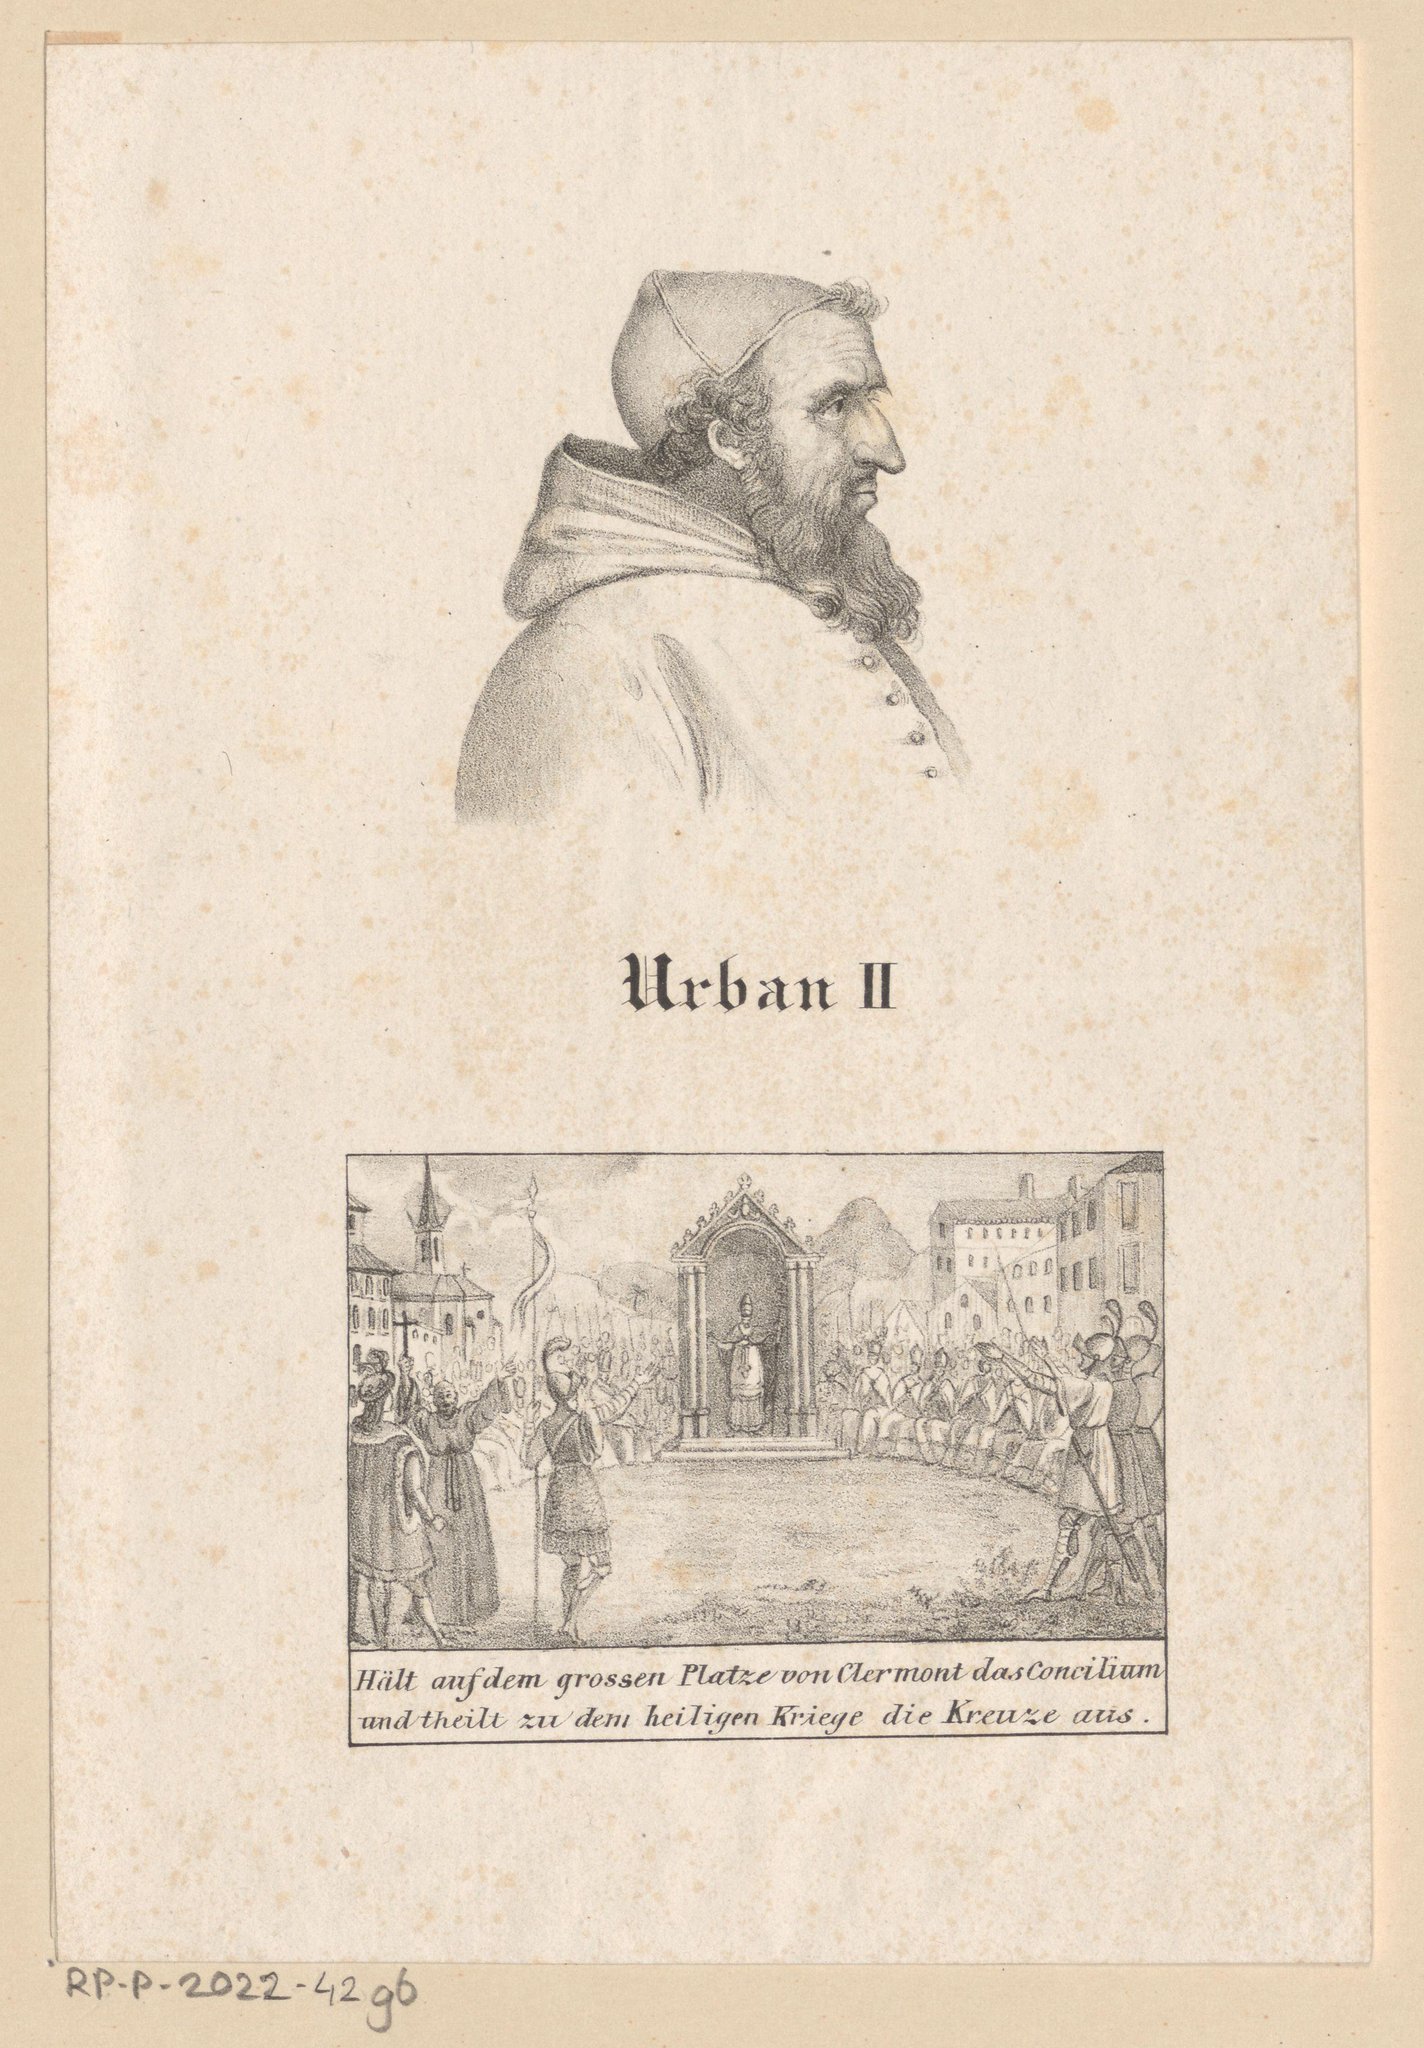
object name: print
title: Oproep tot de eerste kruistocht in Clermont met het portret van paus Urbanus II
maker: Anonymous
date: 1800-1899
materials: paper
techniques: lithograph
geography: germany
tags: rome, historical persons, militant proselytizing: religious war, crusade, etc., council, synod ~ roman catholic church, pope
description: Met een tweeregelig onderschrift in het Duits.